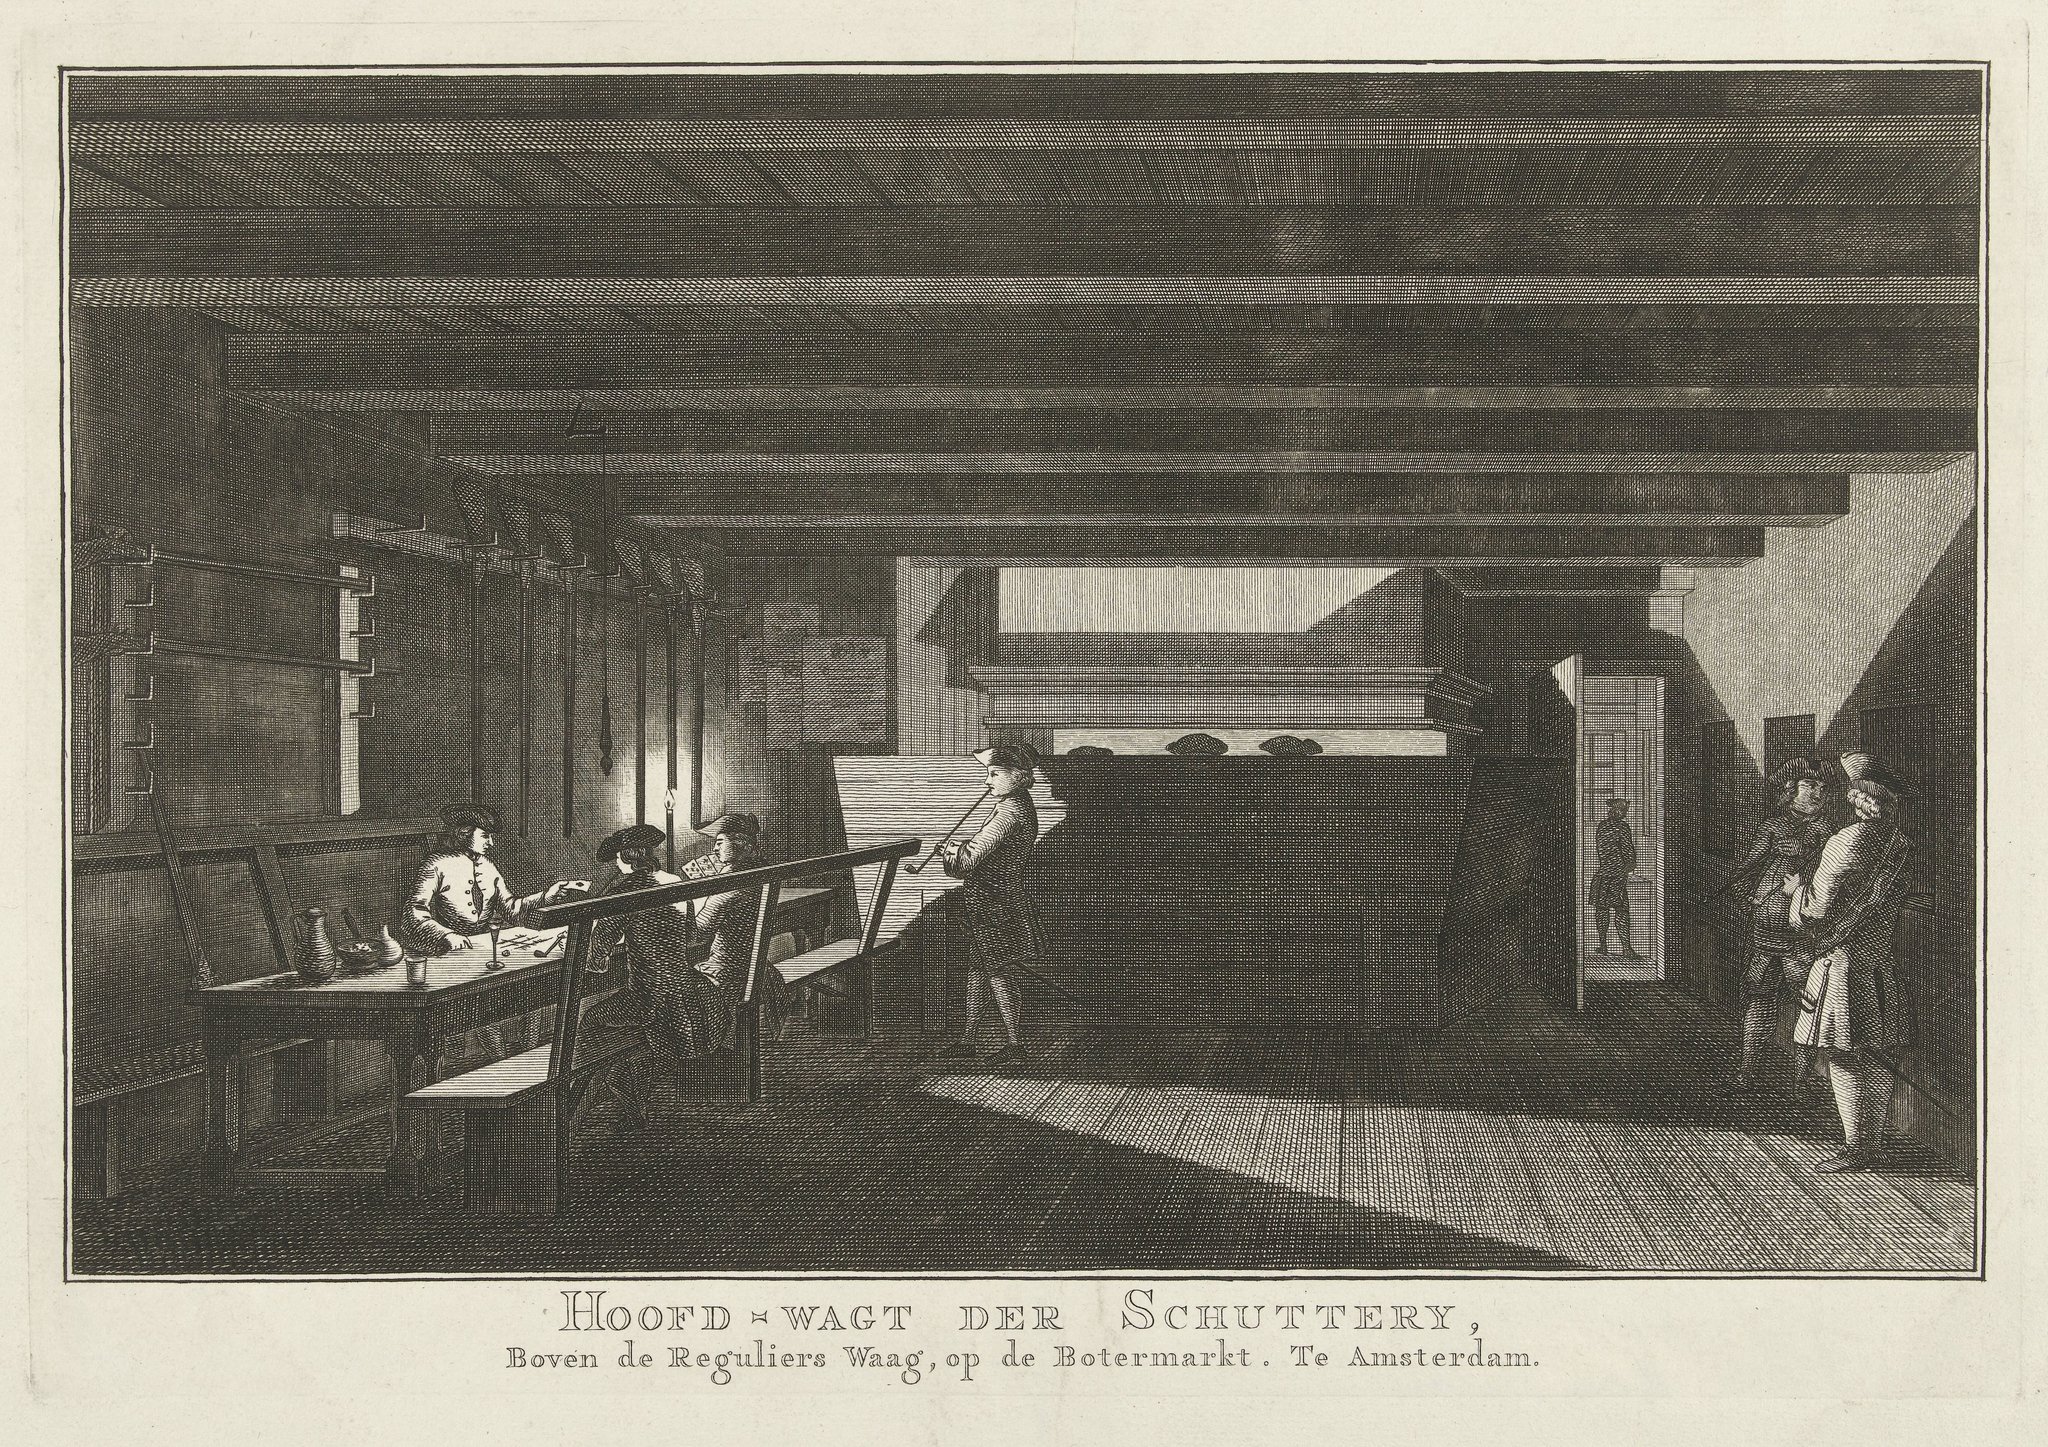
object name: print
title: Interieur van de hoofdwacht van de schutterij op de Botermarkt bij nacht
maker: hendrik van hilten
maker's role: draughtsman, print maker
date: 1750-1793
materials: paper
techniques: etching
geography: northern netherlands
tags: pipe ~ tobacco, card games, playing-cards, guard duty, keeping sentry, night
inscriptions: collector's mark: Lugt 2228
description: Gezicht op het interieur van de hoofdwacht van de schutterij op de Botermarkt te Amsterdam bij nacht, met enkele figuren bij kaarslicht.